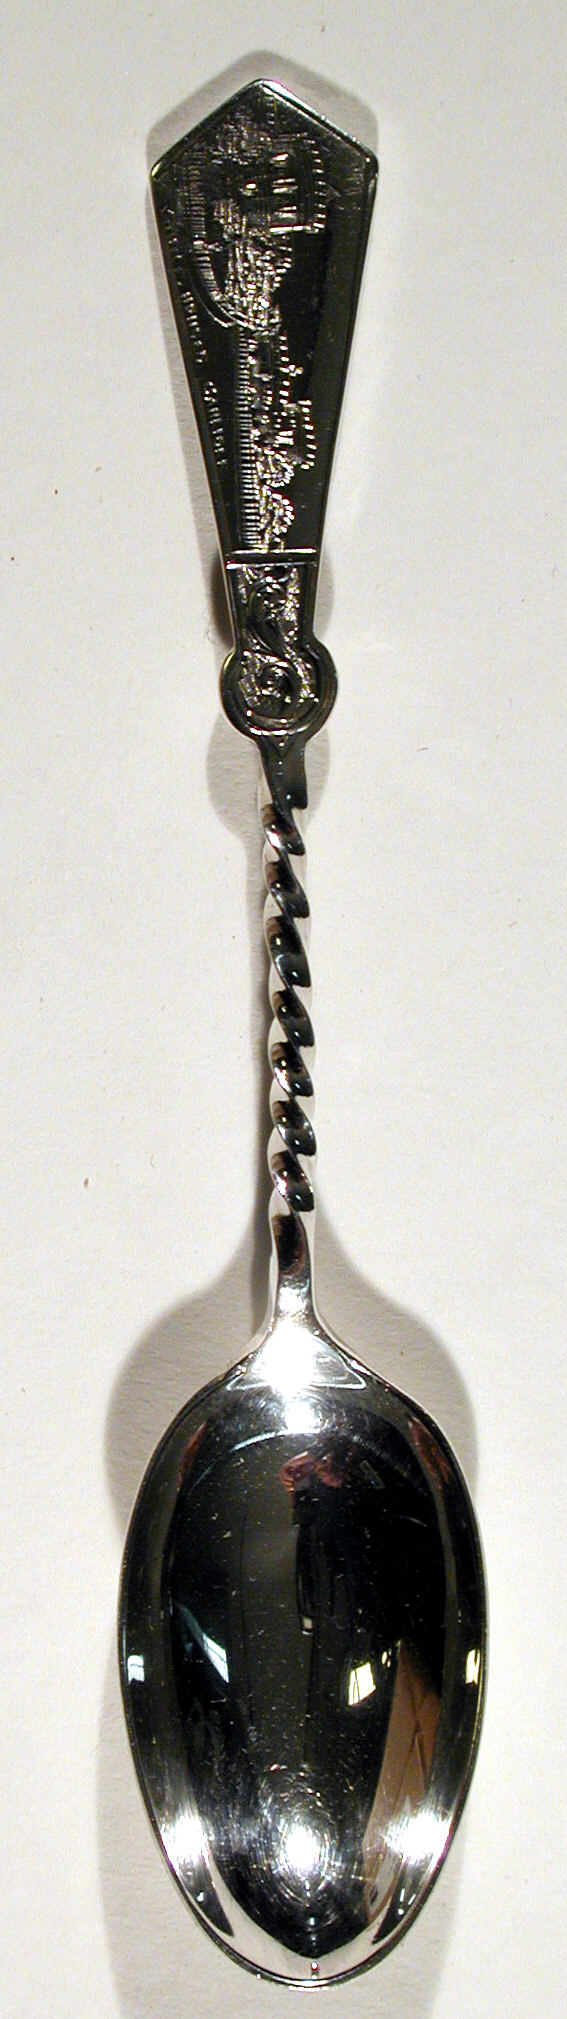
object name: souvenir spoon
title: Souvenir spoon with City of Carlisle Courts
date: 1894-1895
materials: silver